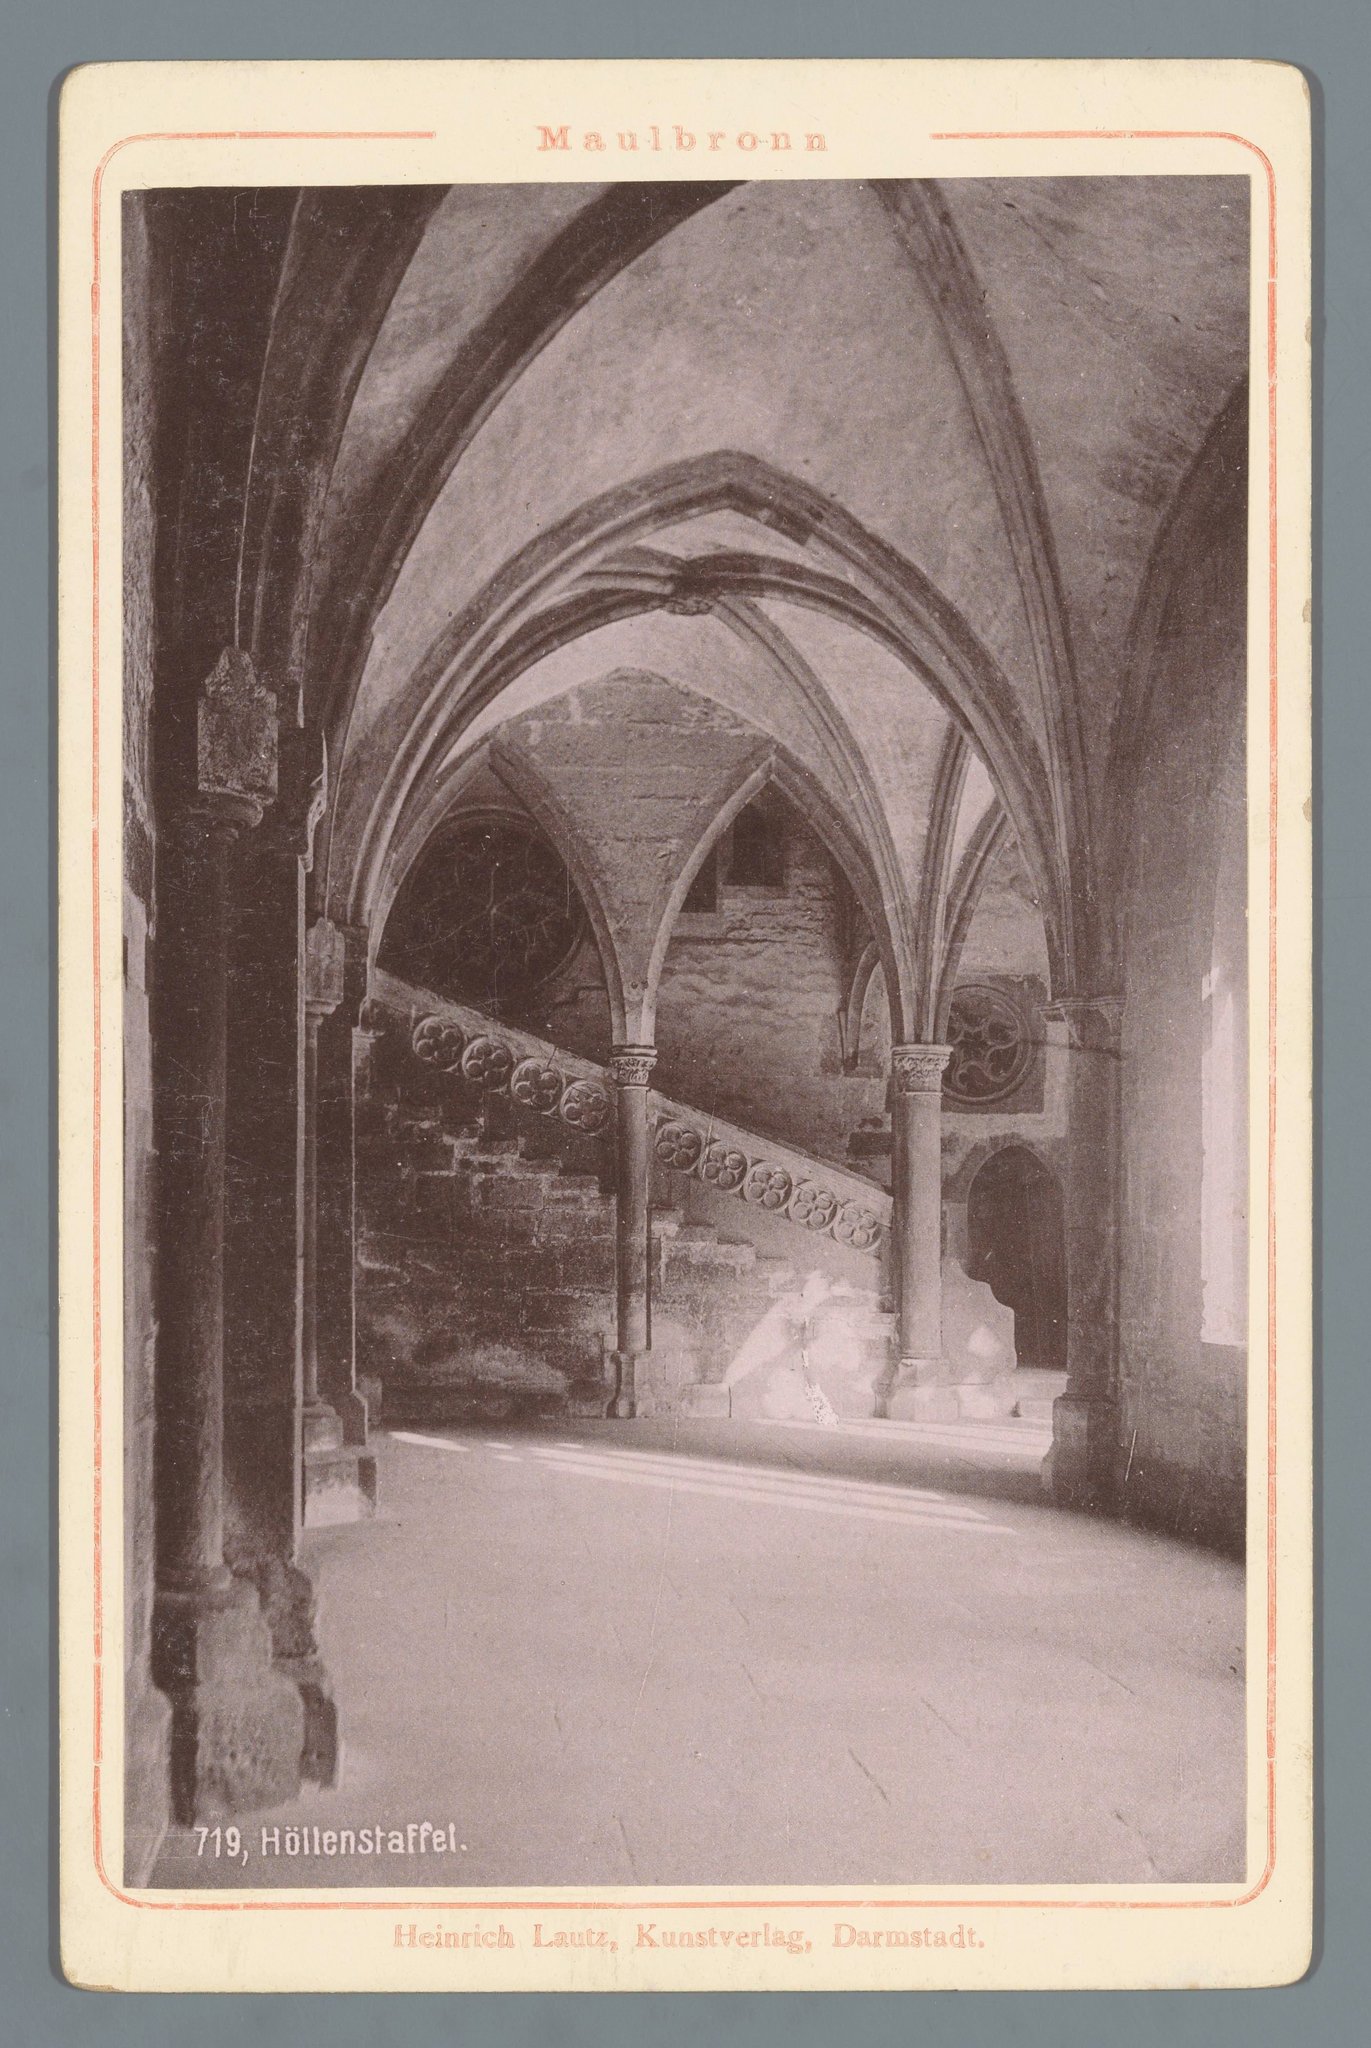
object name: photomechanical print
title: Höllenstaffel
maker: Anonymous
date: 1895-1900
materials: cardboard, paper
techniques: photograph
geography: darmstadt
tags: abbey, monastery, convent ~ roman catholic church, staircase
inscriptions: inscription: ‘17 Juli 1894’, number: ‘719’